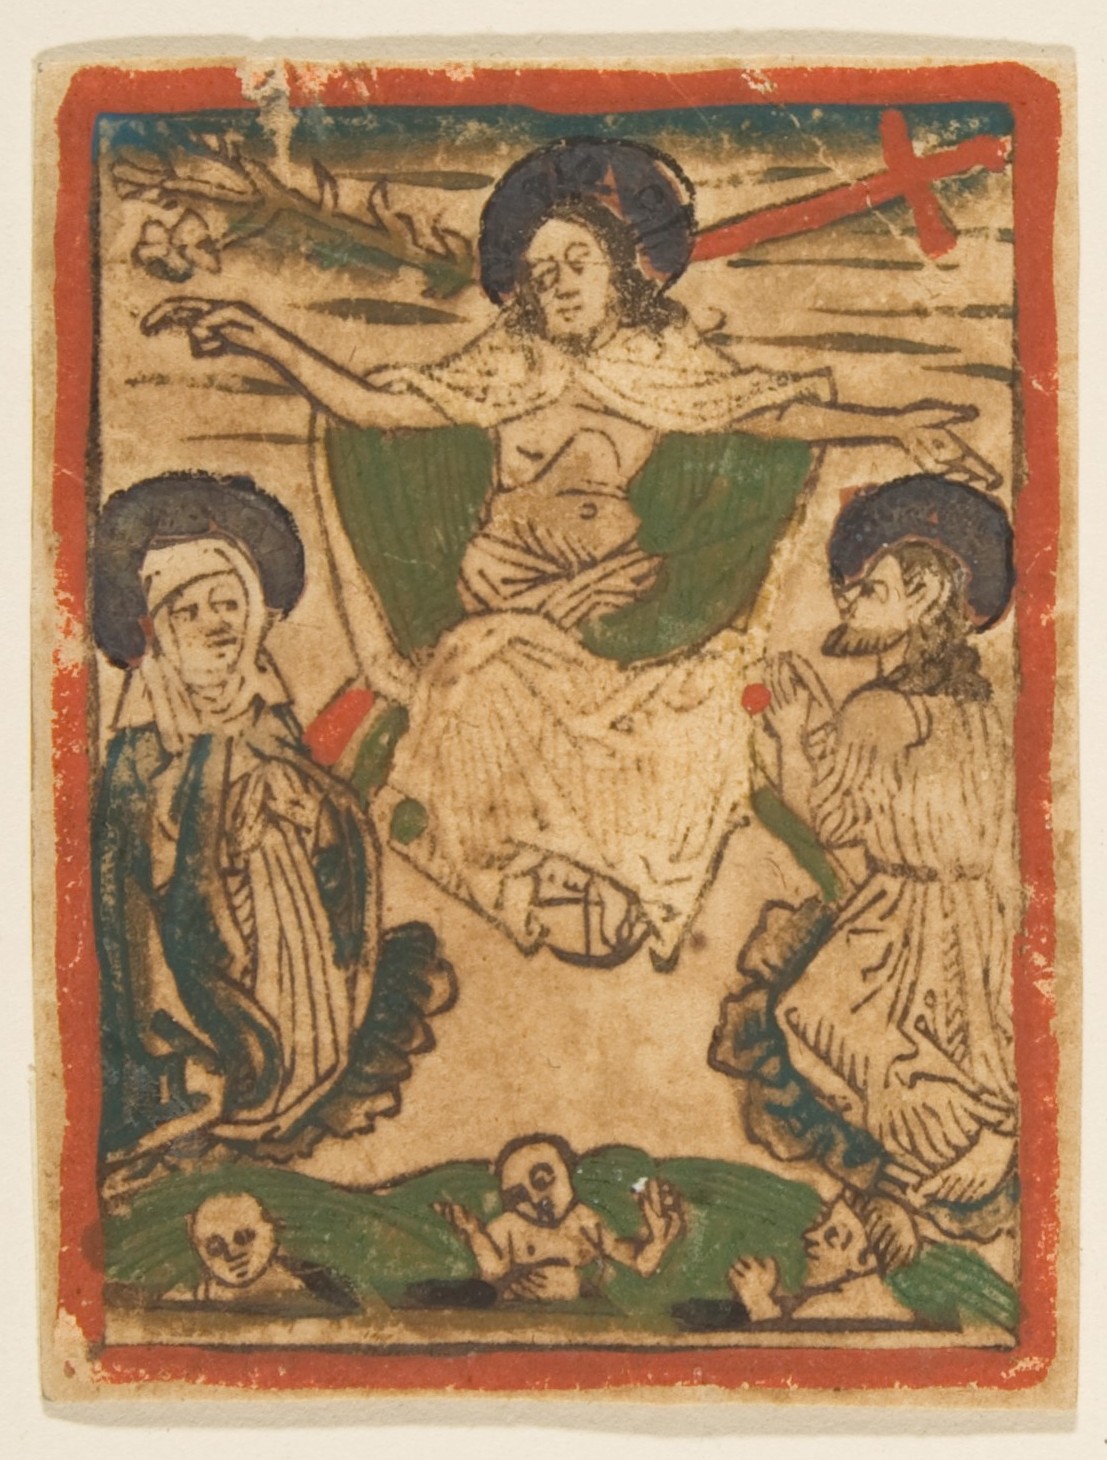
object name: print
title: The Last Judgment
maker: anonymous, german, 15th century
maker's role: artist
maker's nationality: german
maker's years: 1400-1500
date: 1401-1500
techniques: hand coloring, woodcut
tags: men,women,christ,last judgement